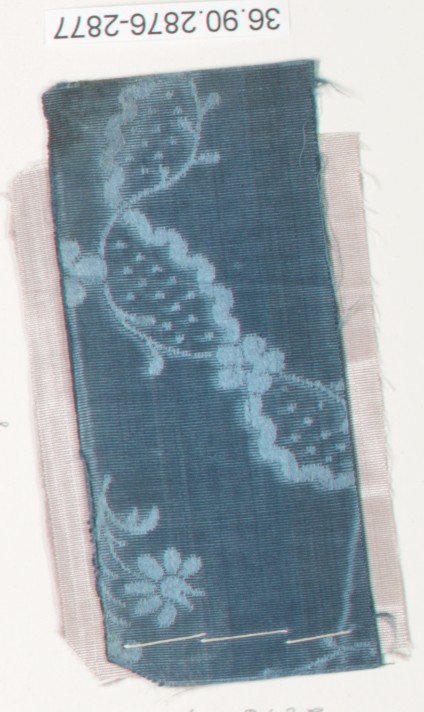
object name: piece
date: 1801-1900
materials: silk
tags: flowers